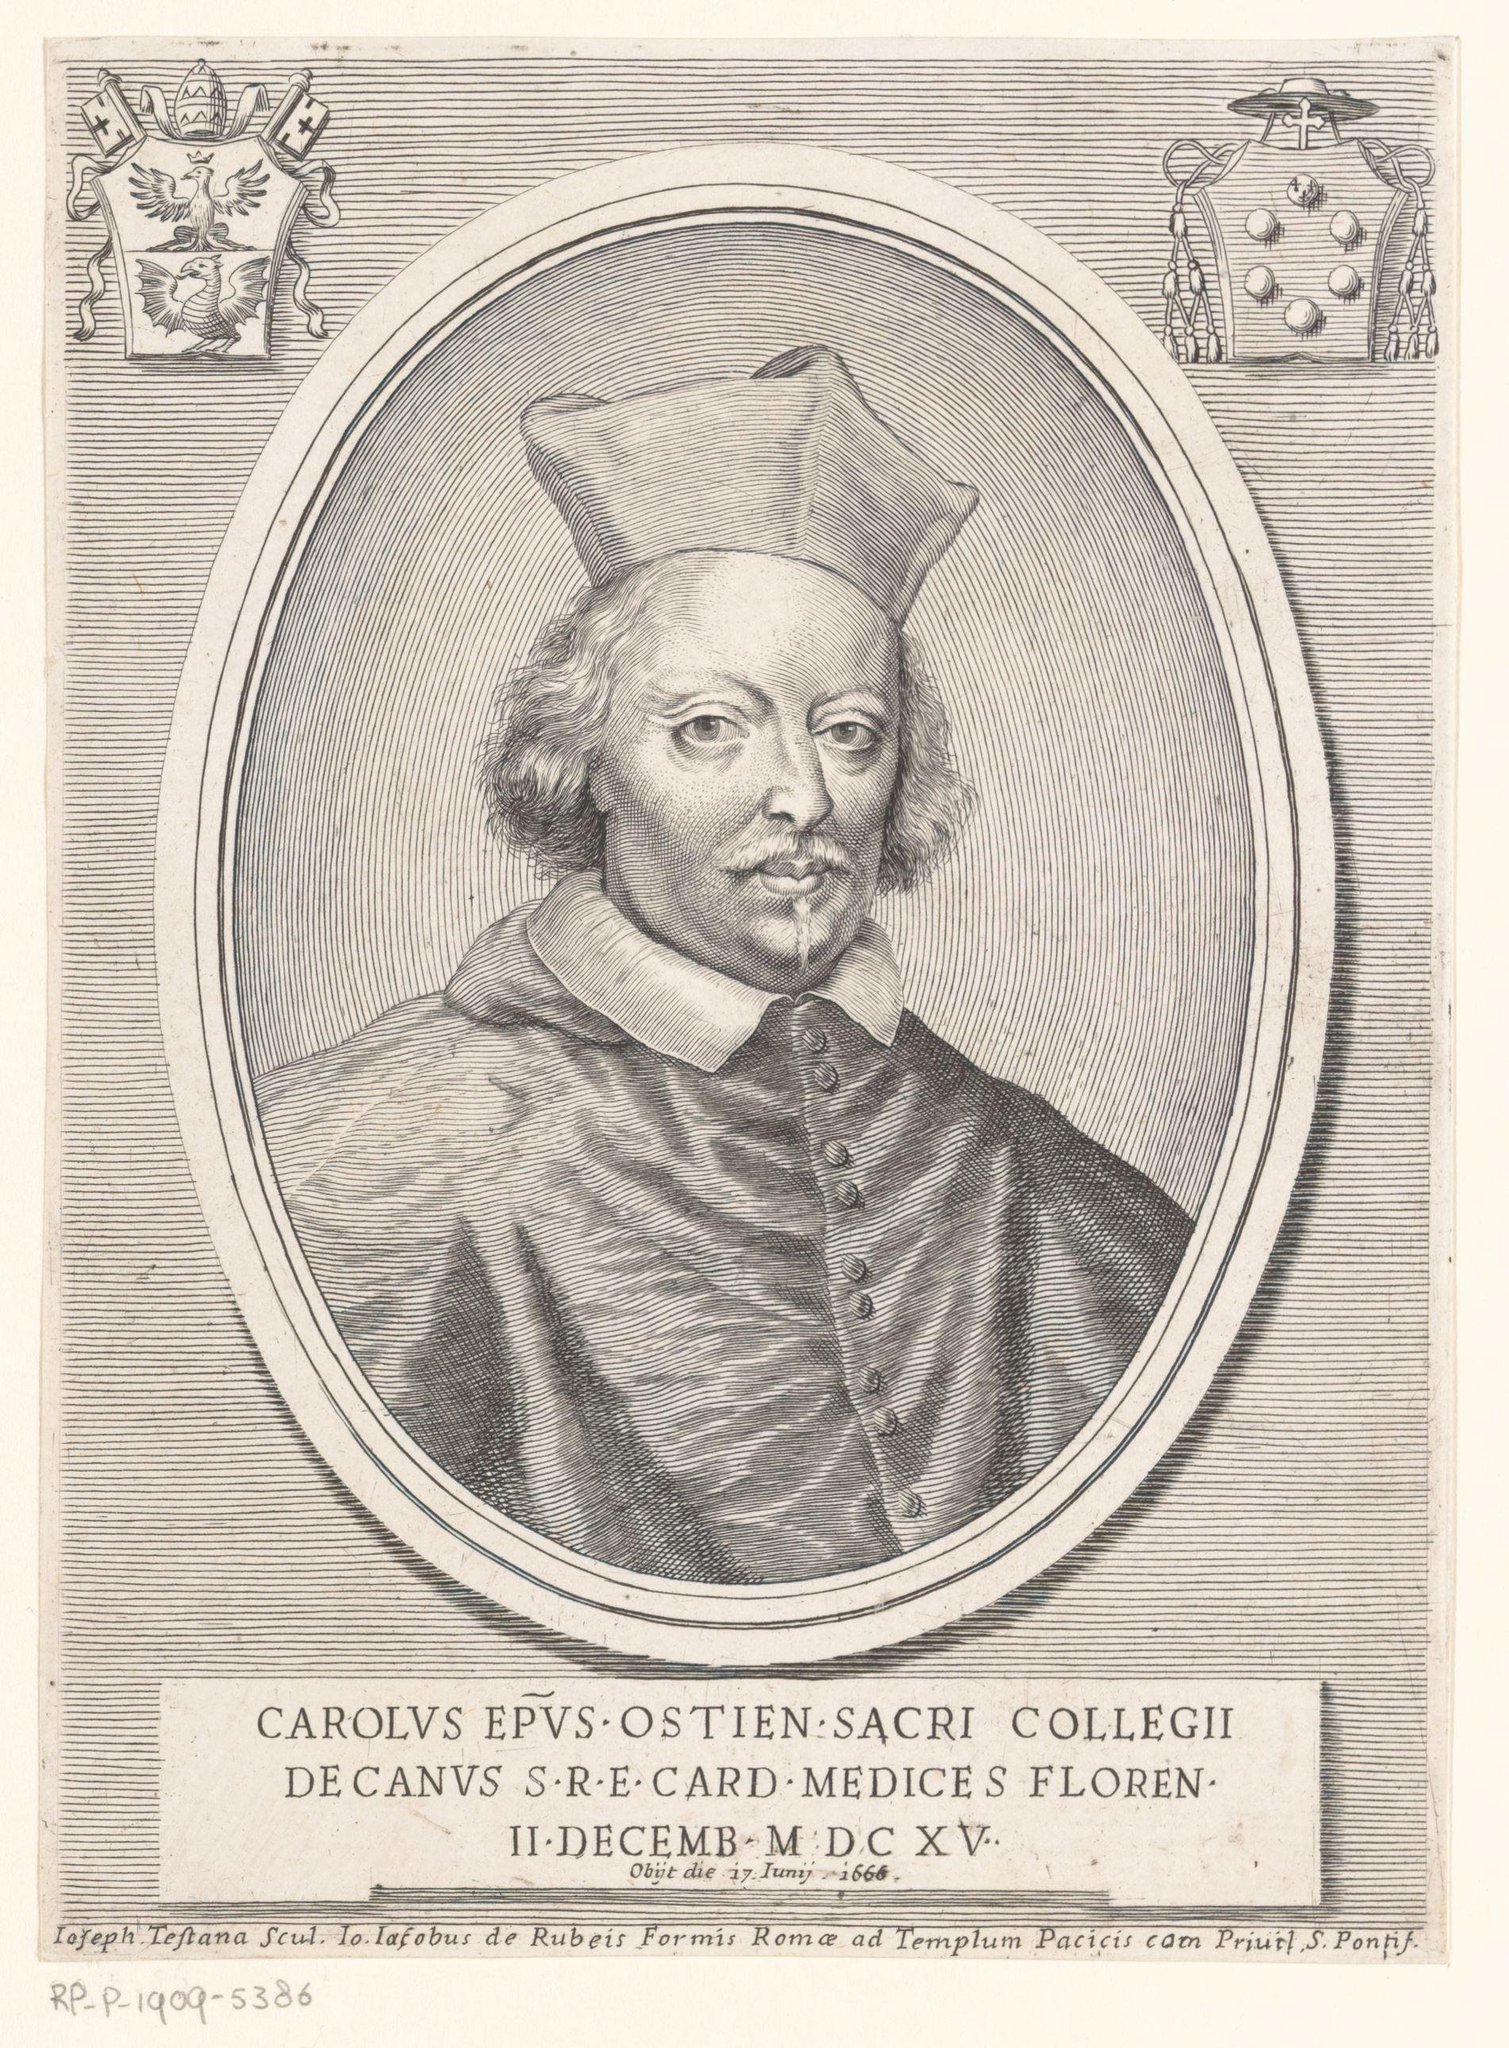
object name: print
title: Effigies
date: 1658-1679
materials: paper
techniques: engraving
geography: vatican city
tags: cardinal, historical persons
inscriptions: collector's mark: Lugt 2228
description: Prent uit een reeks van onbekende omvang met portretten van kardinalen. De prenten werden vanaf 1657 vervaardigd in opdracht van uitgever Giovanni Giacomo de’ Rossi, waarna de productie werd voortgezet onder leiding van zijn opvolgers Domenico de’ Rossi en Lorenzo Filippo de’ Rossi, en ten slotte onder leiding van de Calcographia R.C.A.